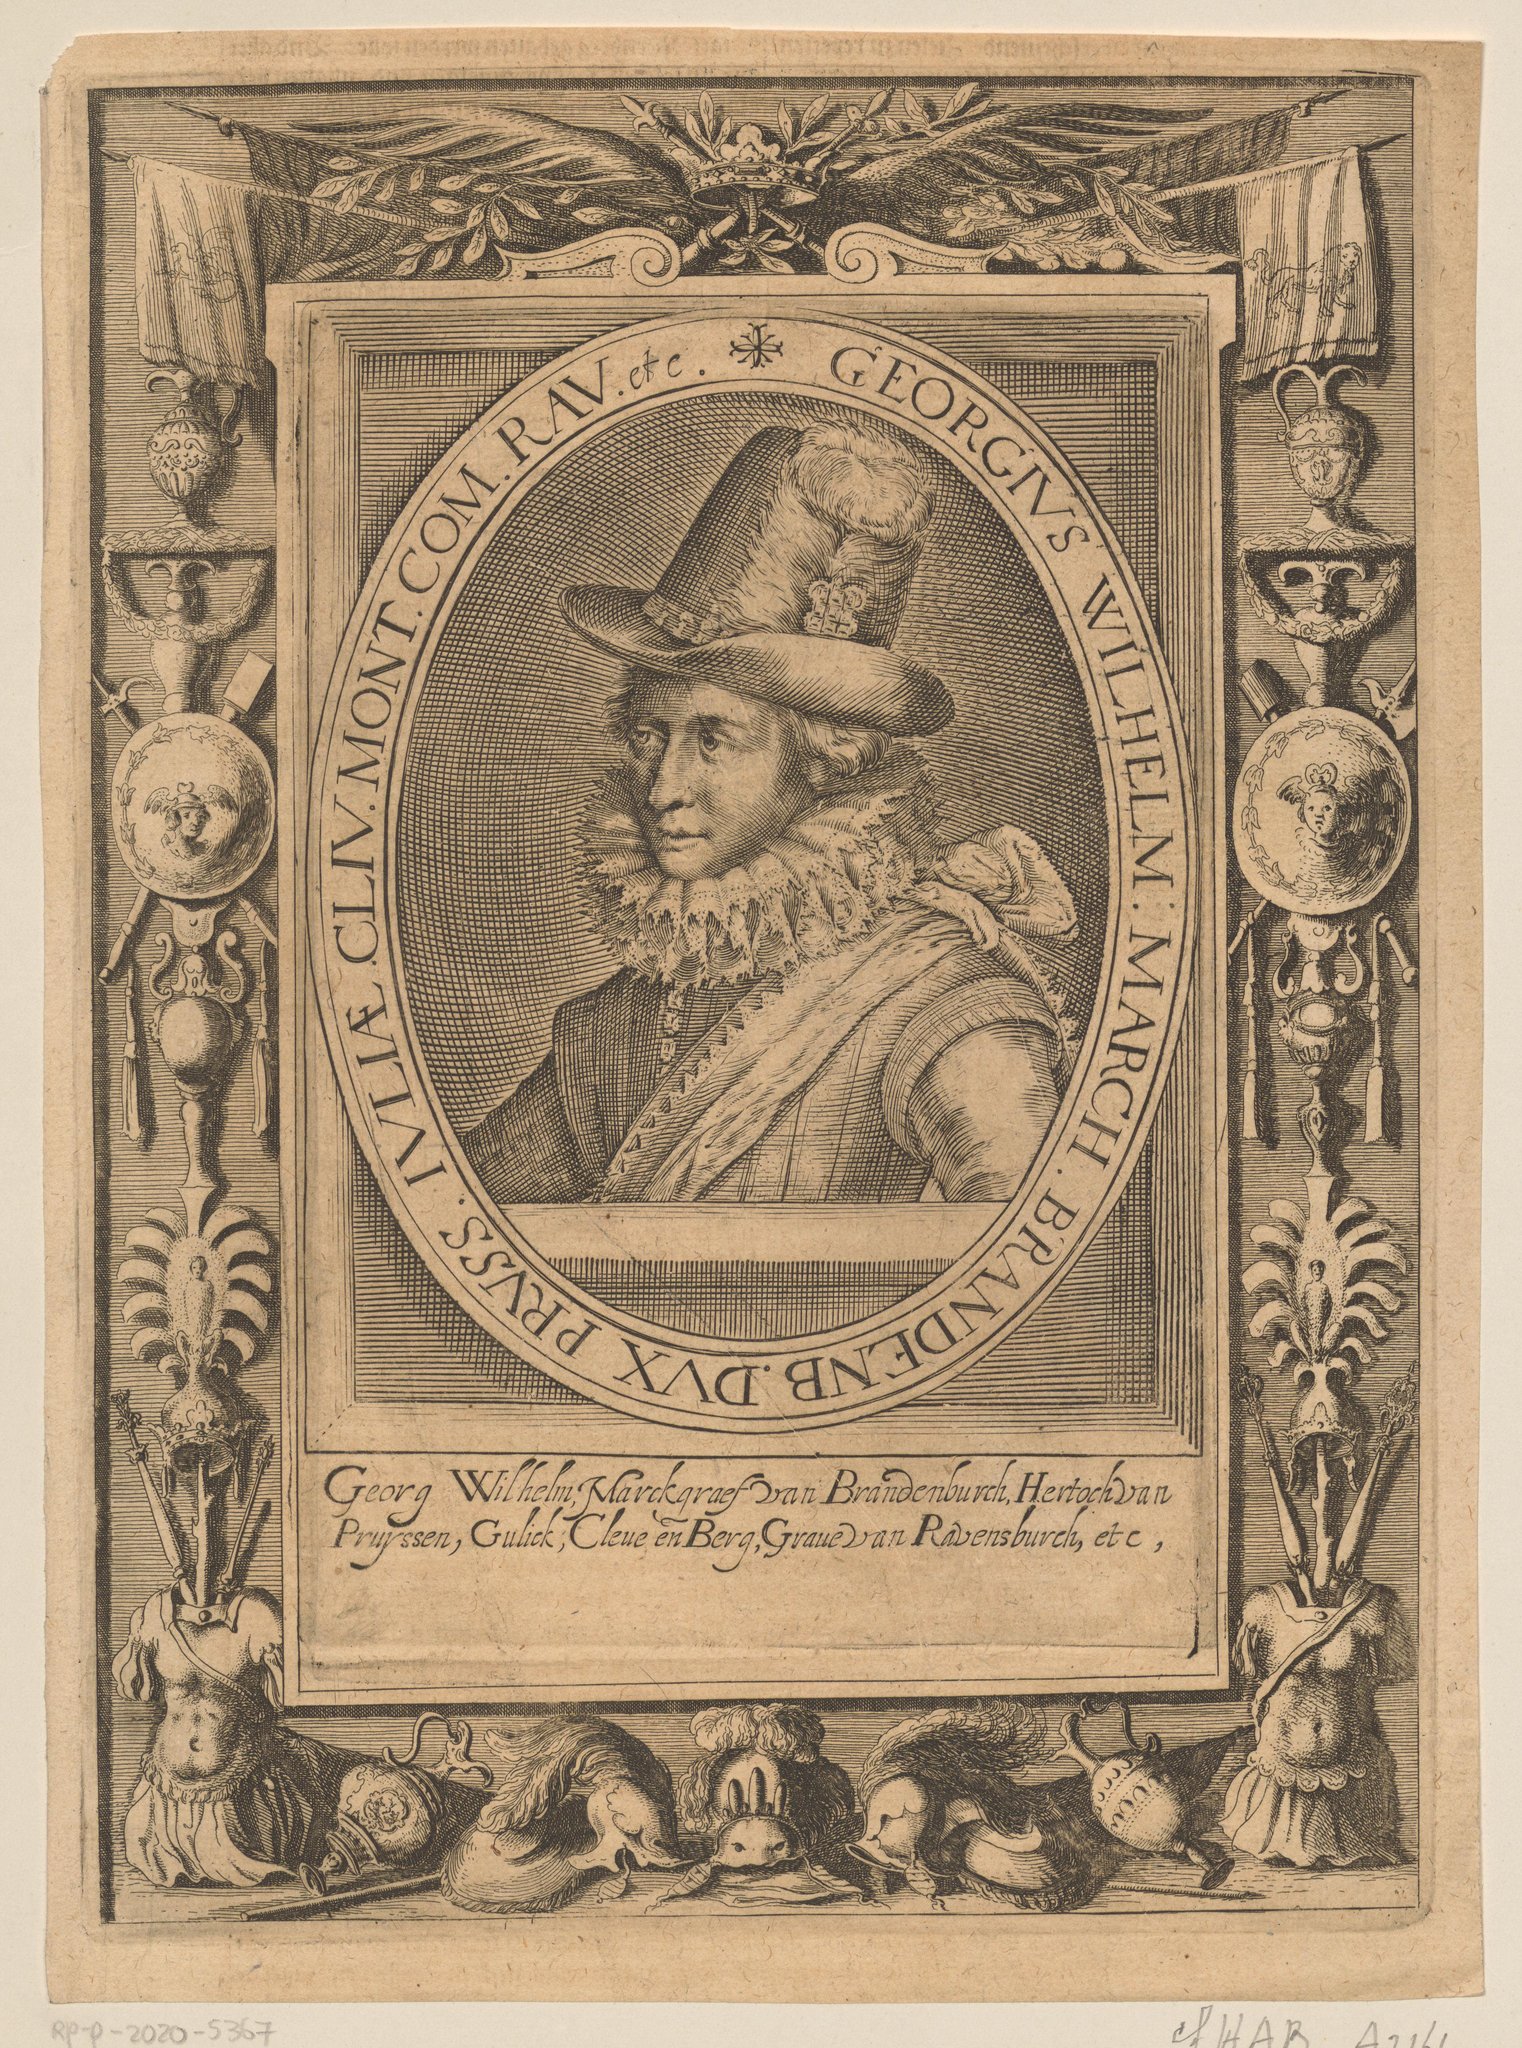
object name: print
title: Portret van Georg Wilhelm van Brandenburg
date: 1579-1625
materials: paper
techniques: engraving, etching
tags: cologne, 'tropaion', i.e. decorative ornament ~ weapons, armour, historical persons, cupids: 'amores', 'amoretti', 'putti'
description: Andere staat van prent gebruikt in: Clerck, Nicolaes de. Princelyck cabinet: verthoonende t'leven afcomste ende afbeeldingen der voornaemste vorste[n] princes graven en[de] heeren van Europa (...). [Delft]: erven Nicolaes de Clerck, 1625, p. 53.